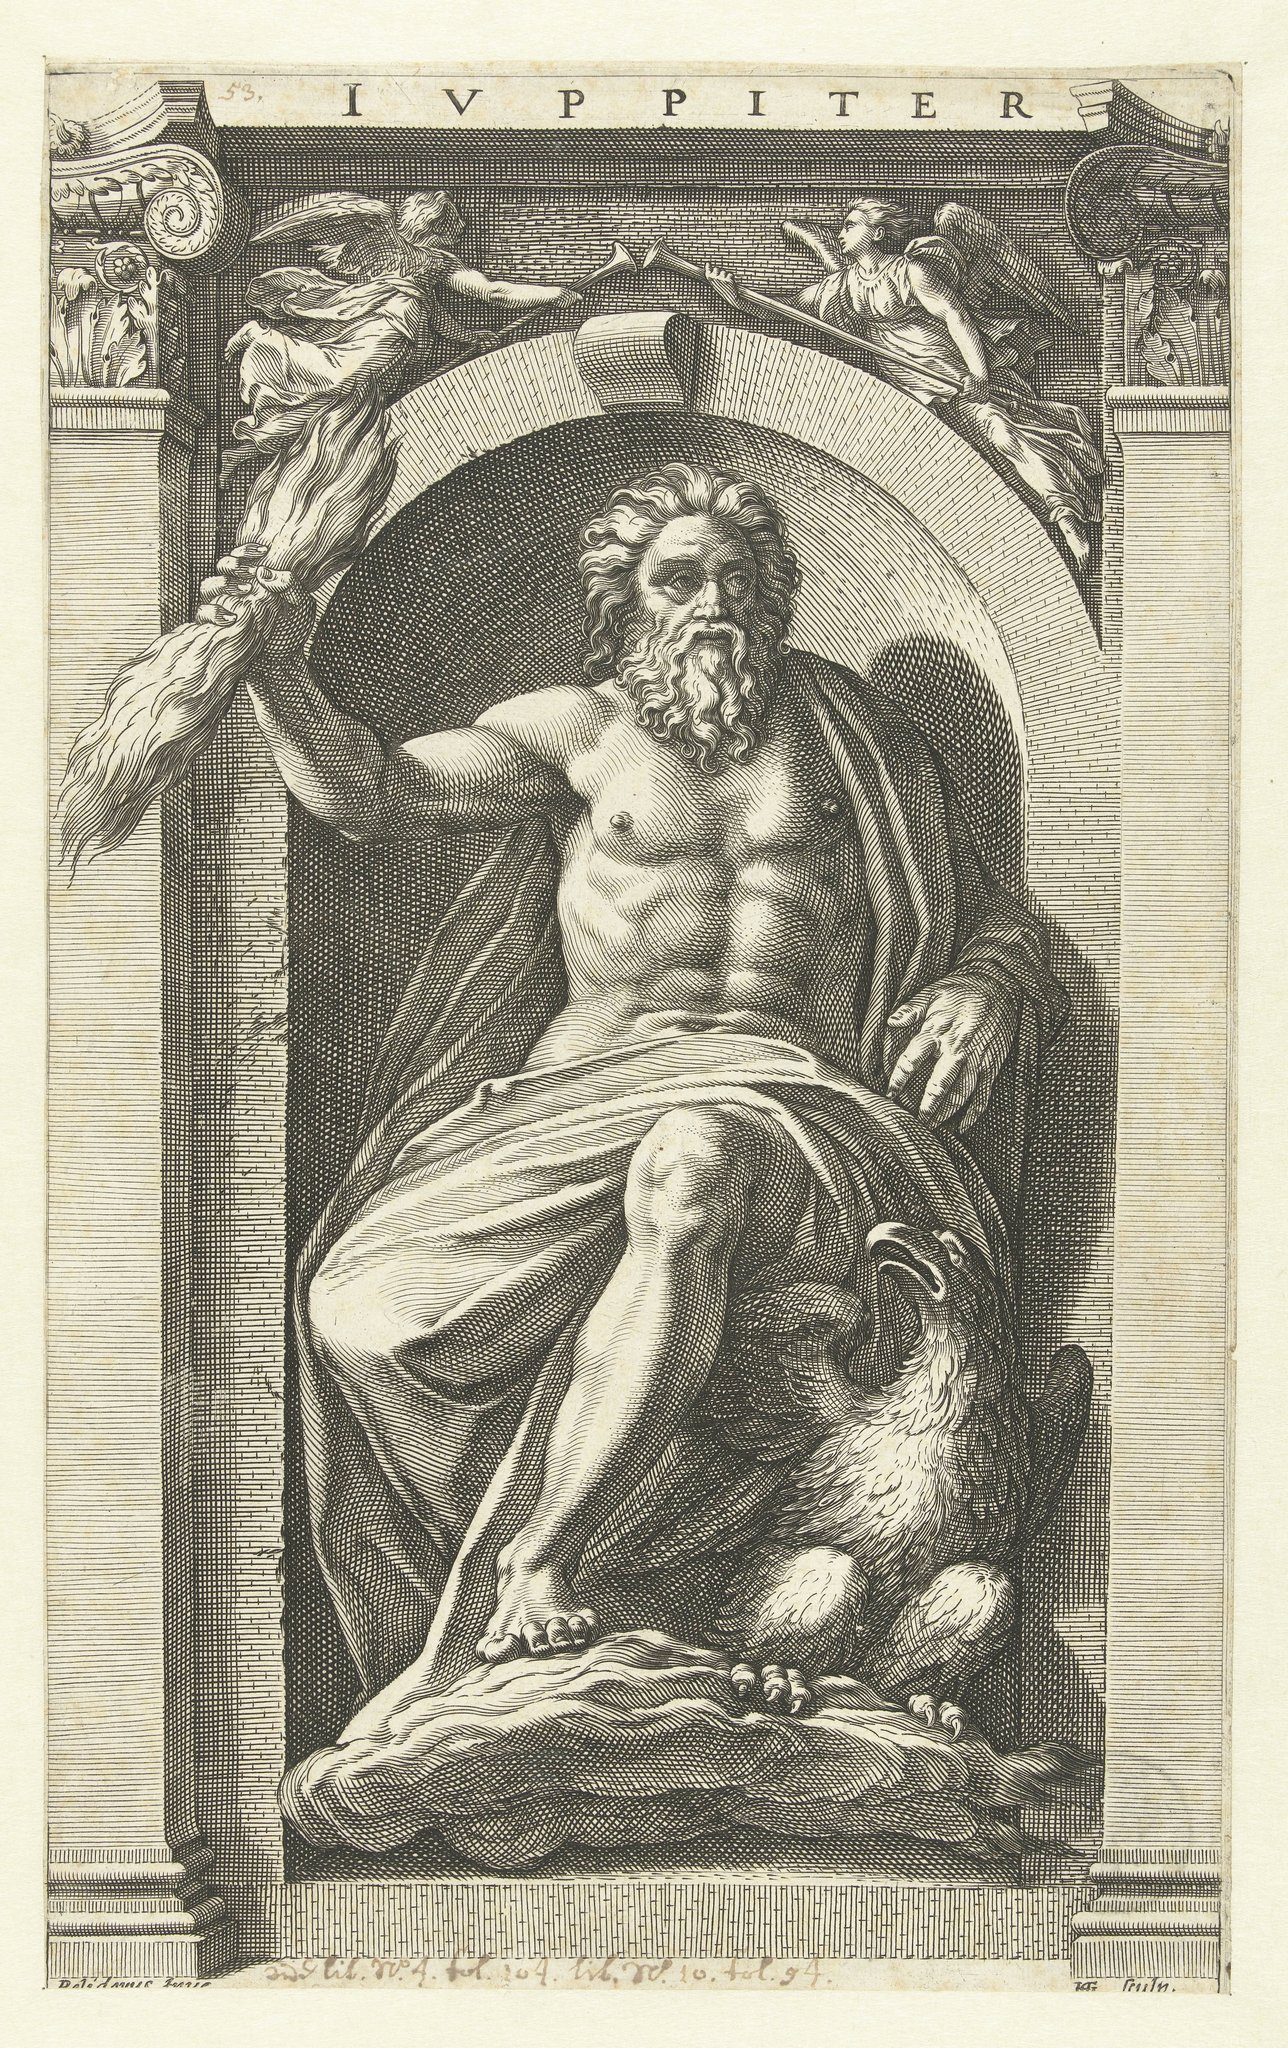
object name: print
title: Juppiter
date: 1592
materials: paper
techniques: engraving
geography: haarlem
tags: (story of) jupiter (zeus)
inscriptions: collector's mark: Lugt 11, inscription, collector's mark: ‘Hinloopen’, collector's mark: Lugt 10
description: Jupiter, gezeten in een nis, een bliksemschicht in zijn rechterhand, een adelaar bij zijn linkervoet. Deze prent is onderdeel van een serie van acht prenten van klassieke goden, gebaseerd op schilderingen van Polidoro da Caravaggio op de façade van een Romeins huis, door Goltzius in Rome gezien en nagetekend.